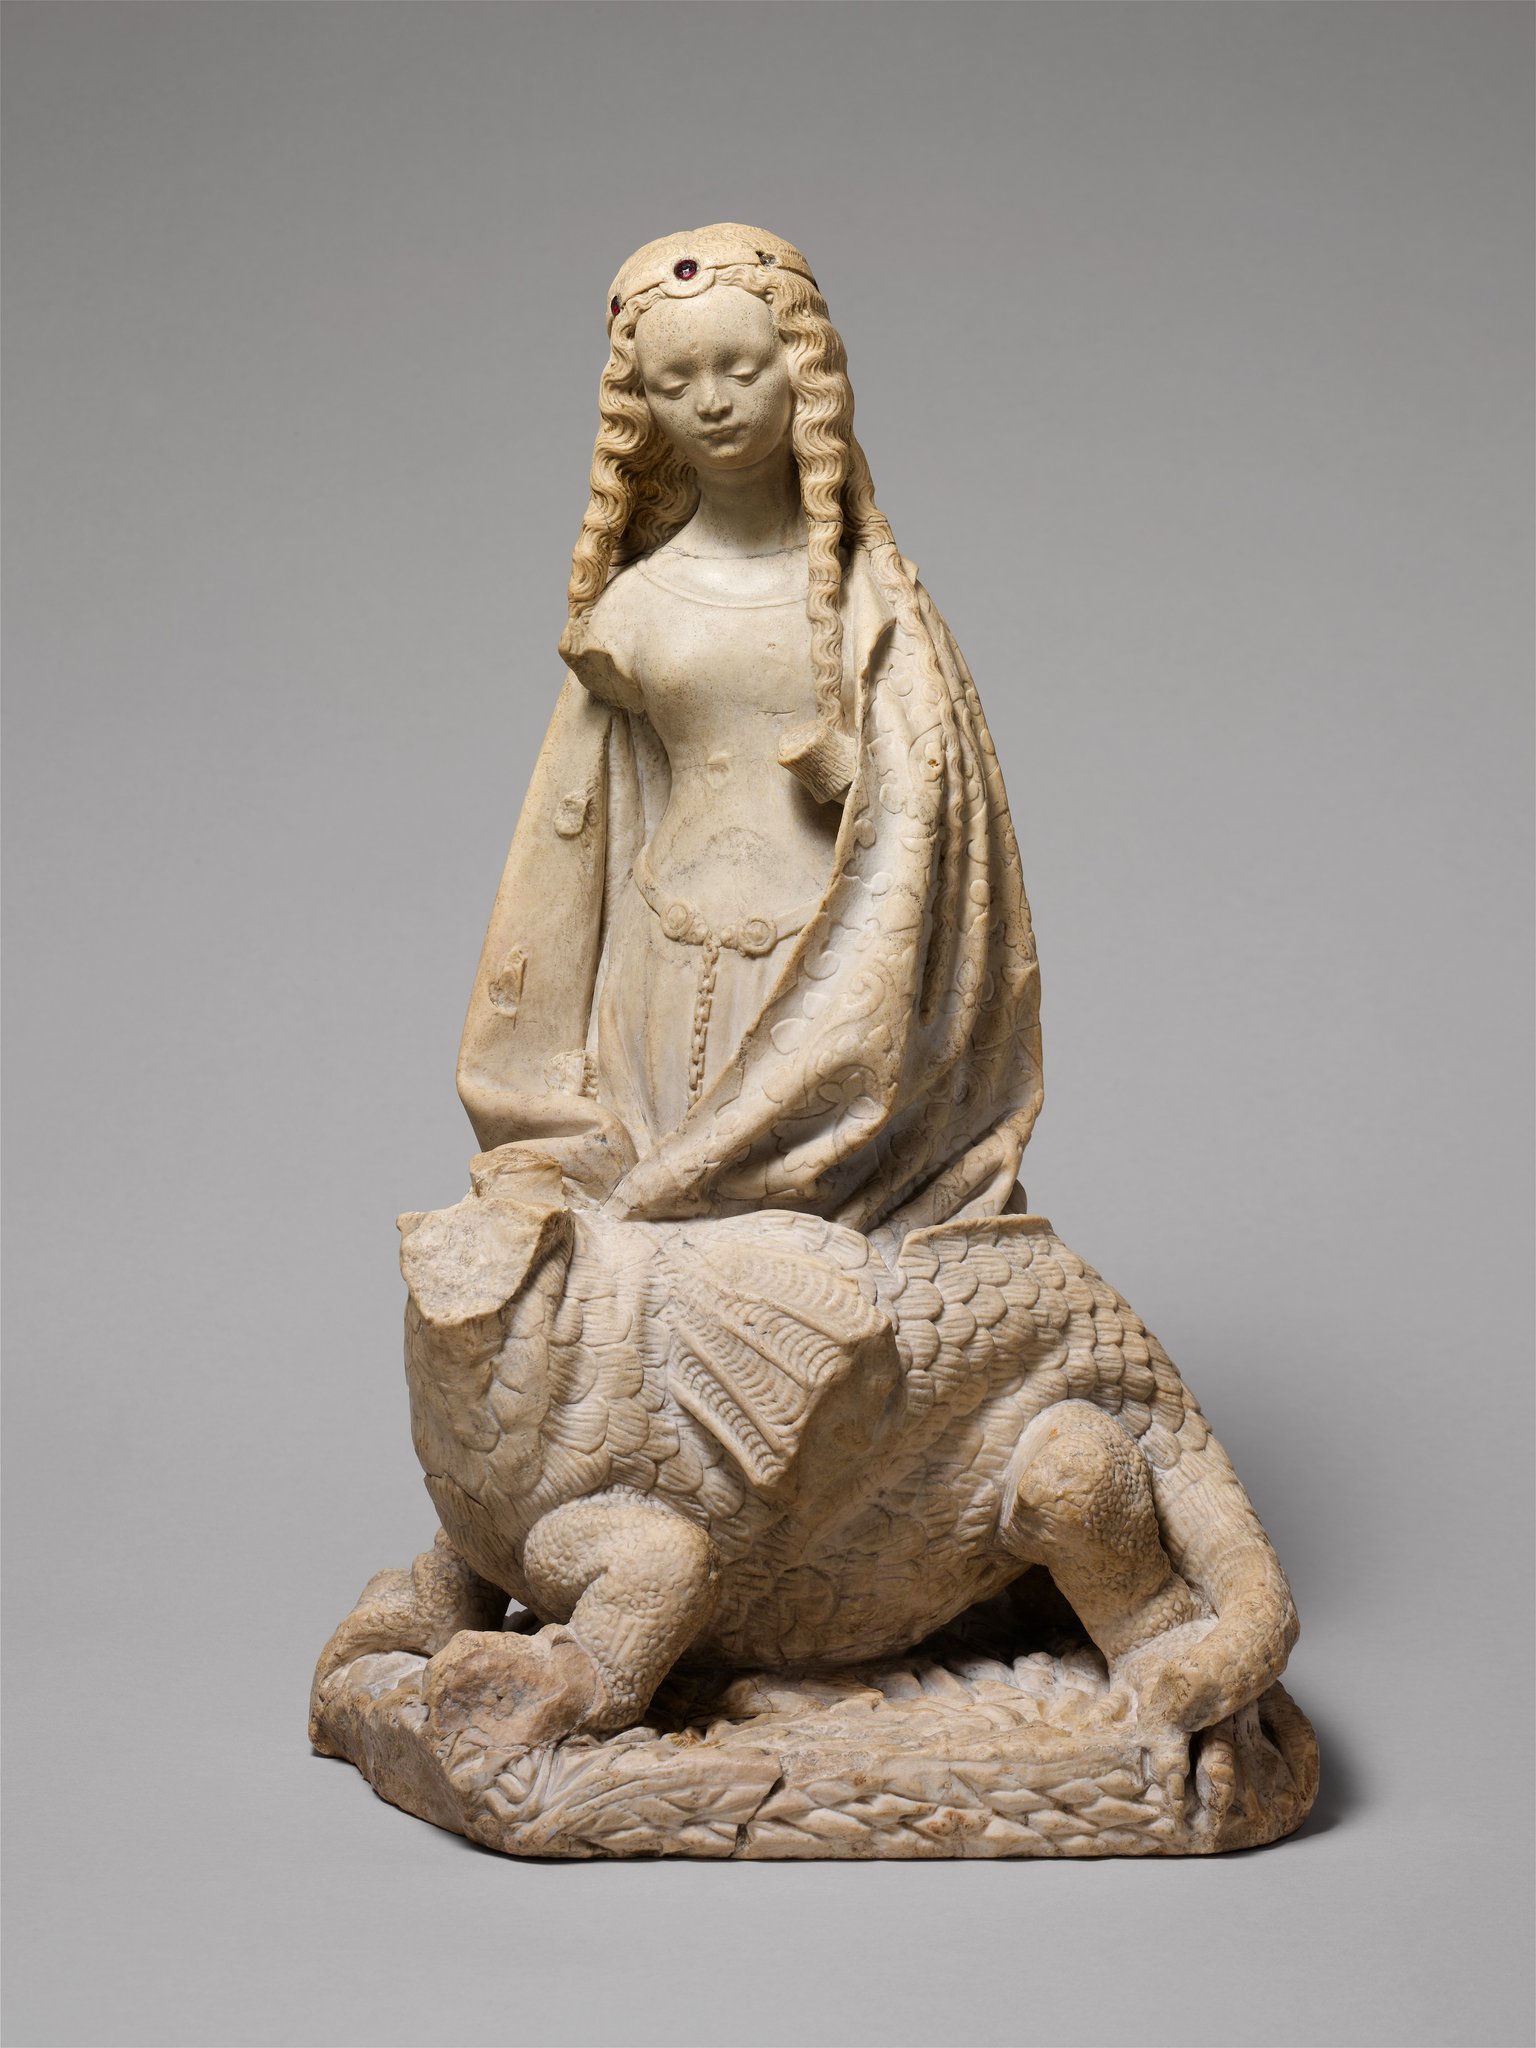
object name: statuette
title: Saint Margaret of Antioch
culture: french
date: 1475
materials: alabaster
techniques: gilding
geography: toulouse (?)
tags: women,dragons,saints